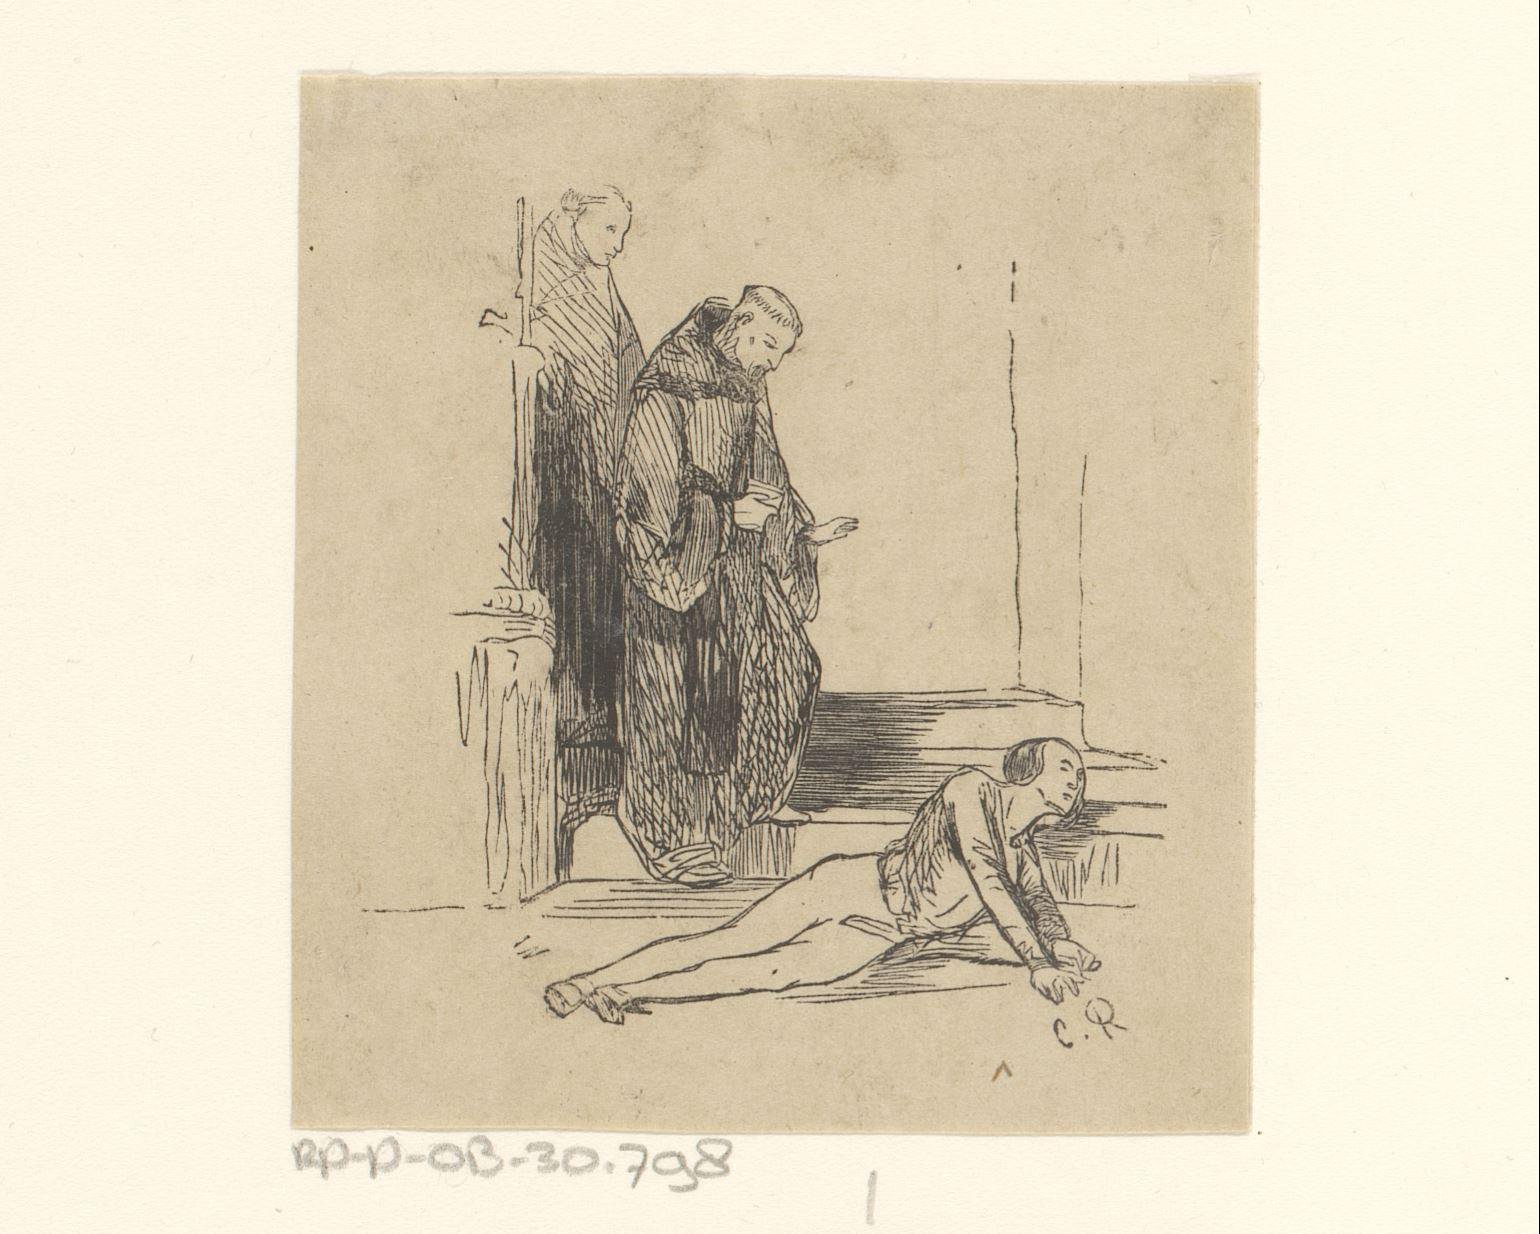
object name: print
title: Twee monniken kijkend naar een man die op de grond ligt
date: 1836-1912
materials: paper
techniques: engraving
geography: netherlands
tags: adult man (+ lying), monk(s), friar(s)